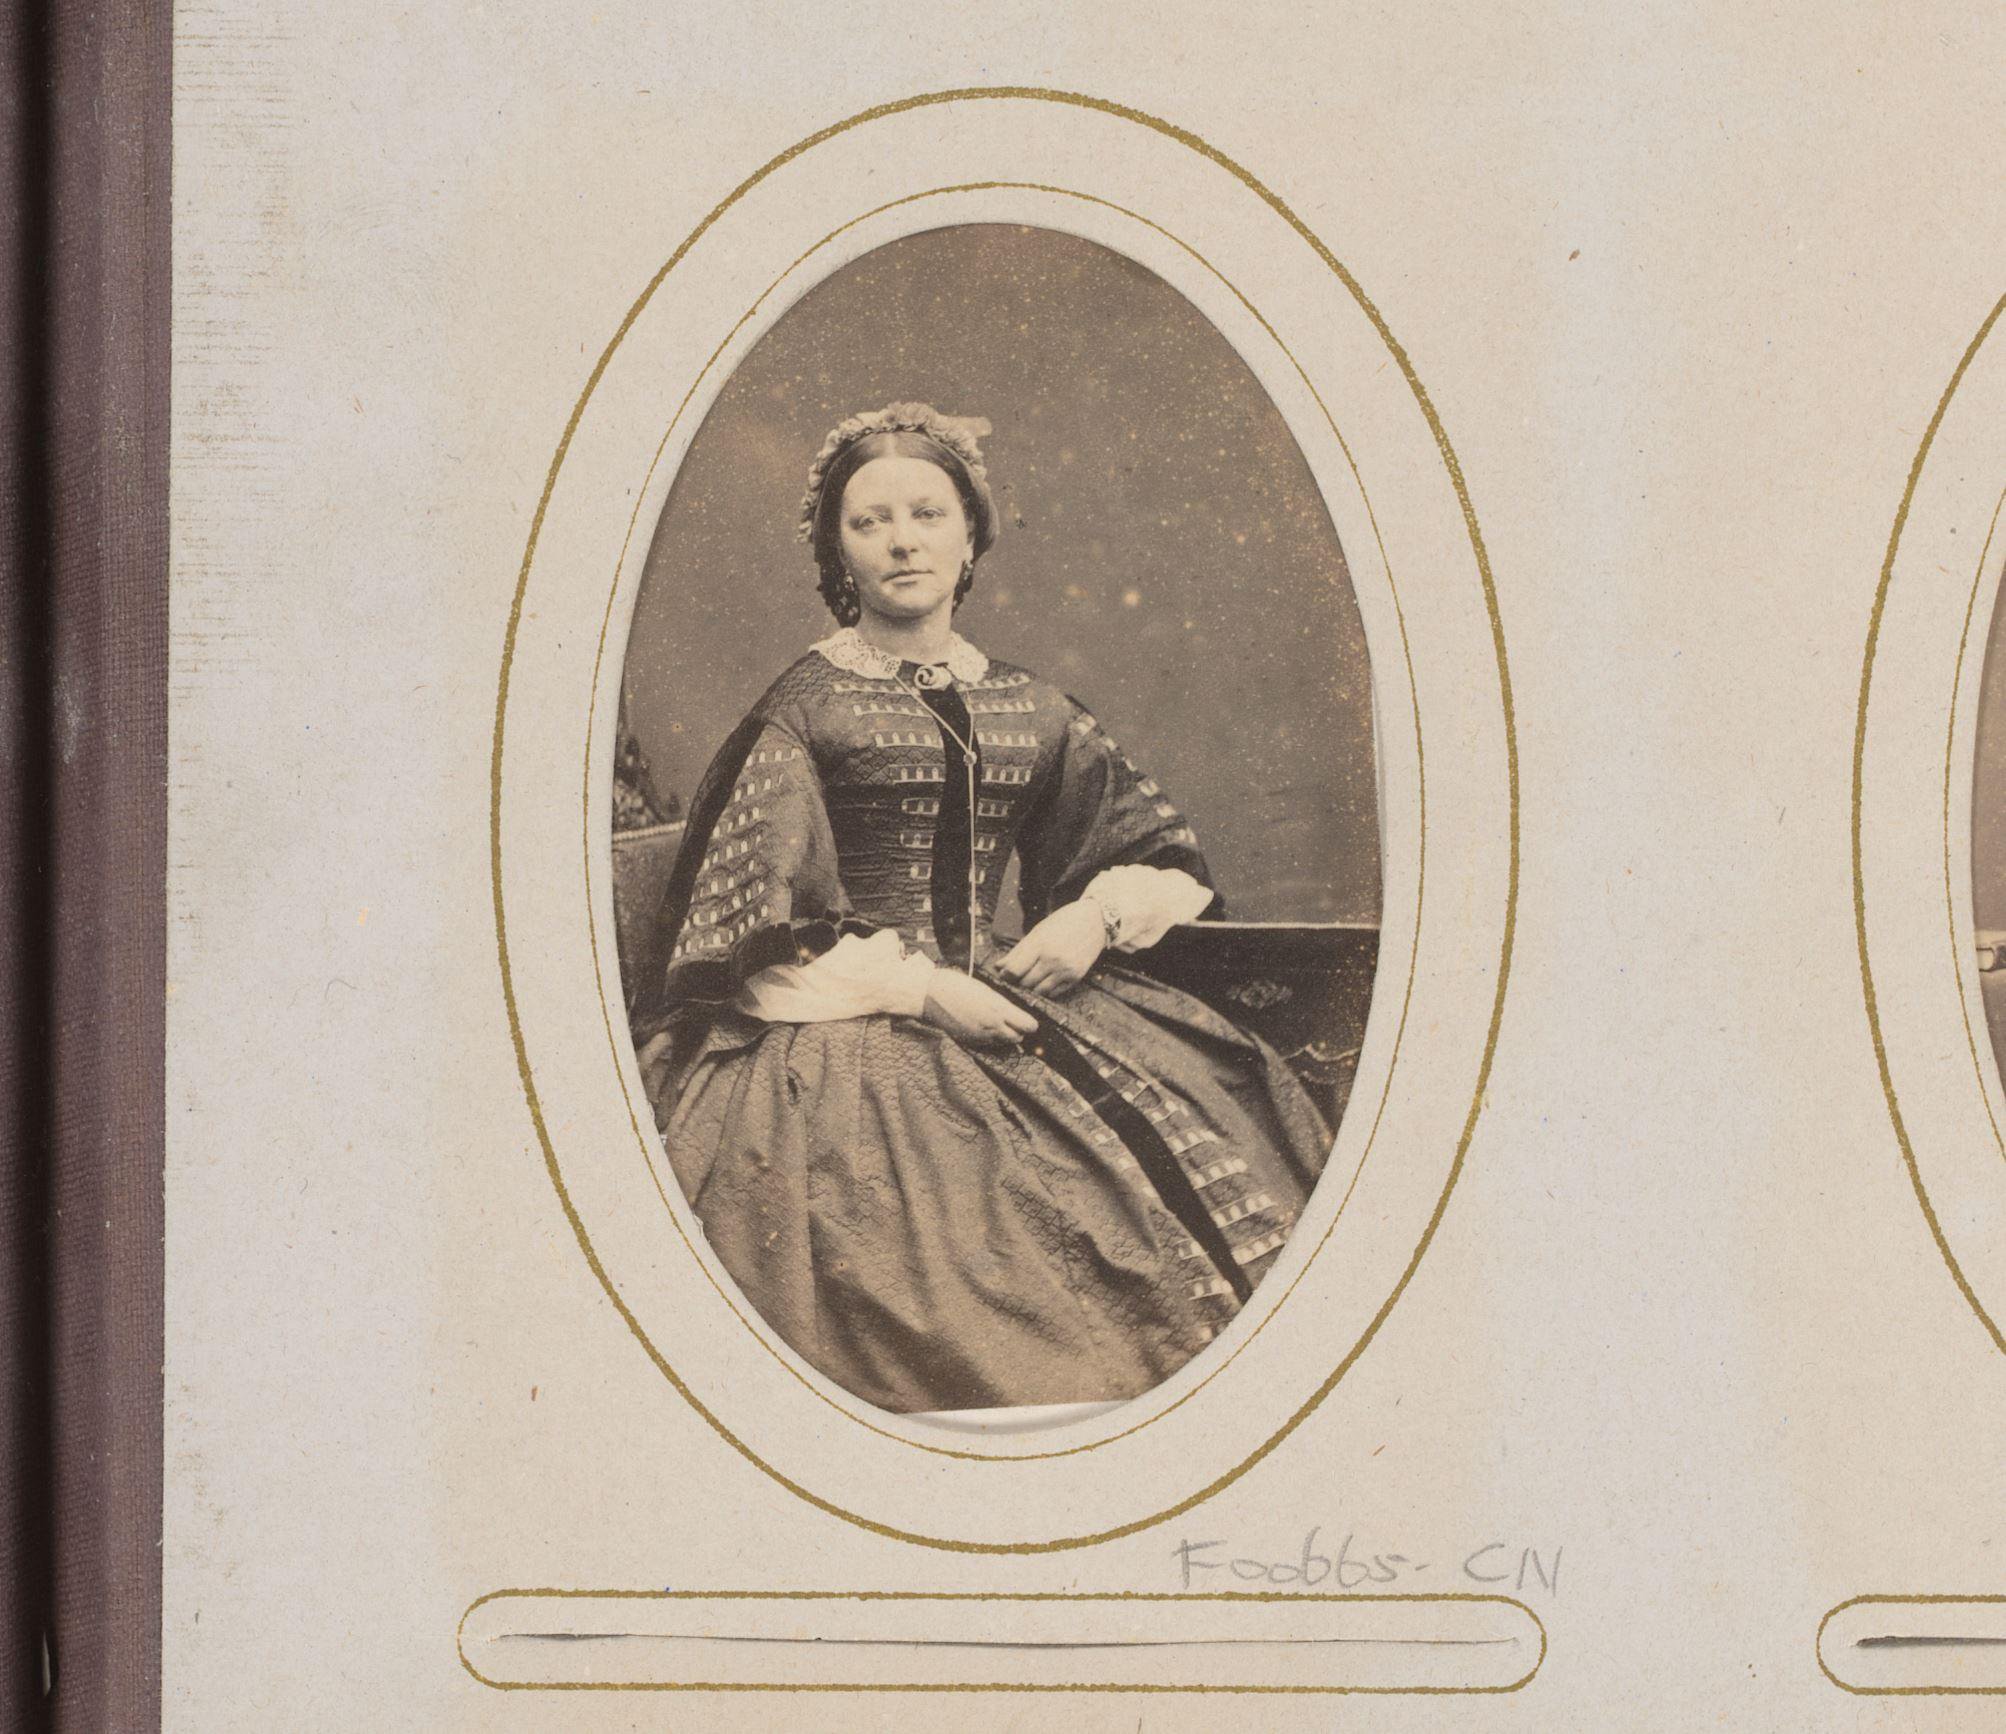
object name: carte de visite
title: Portret van een vrouw met muts en ketting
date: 1857-1864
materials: cardboard, photographic support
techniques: albumen print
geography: amsterdam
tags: historical persons - bb - woman, head-gear: cap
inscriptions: inscription: ‘Photogr Atelier/ Wegner & Mottu/ Prinsengracht BB, 439/ Amsterdam’